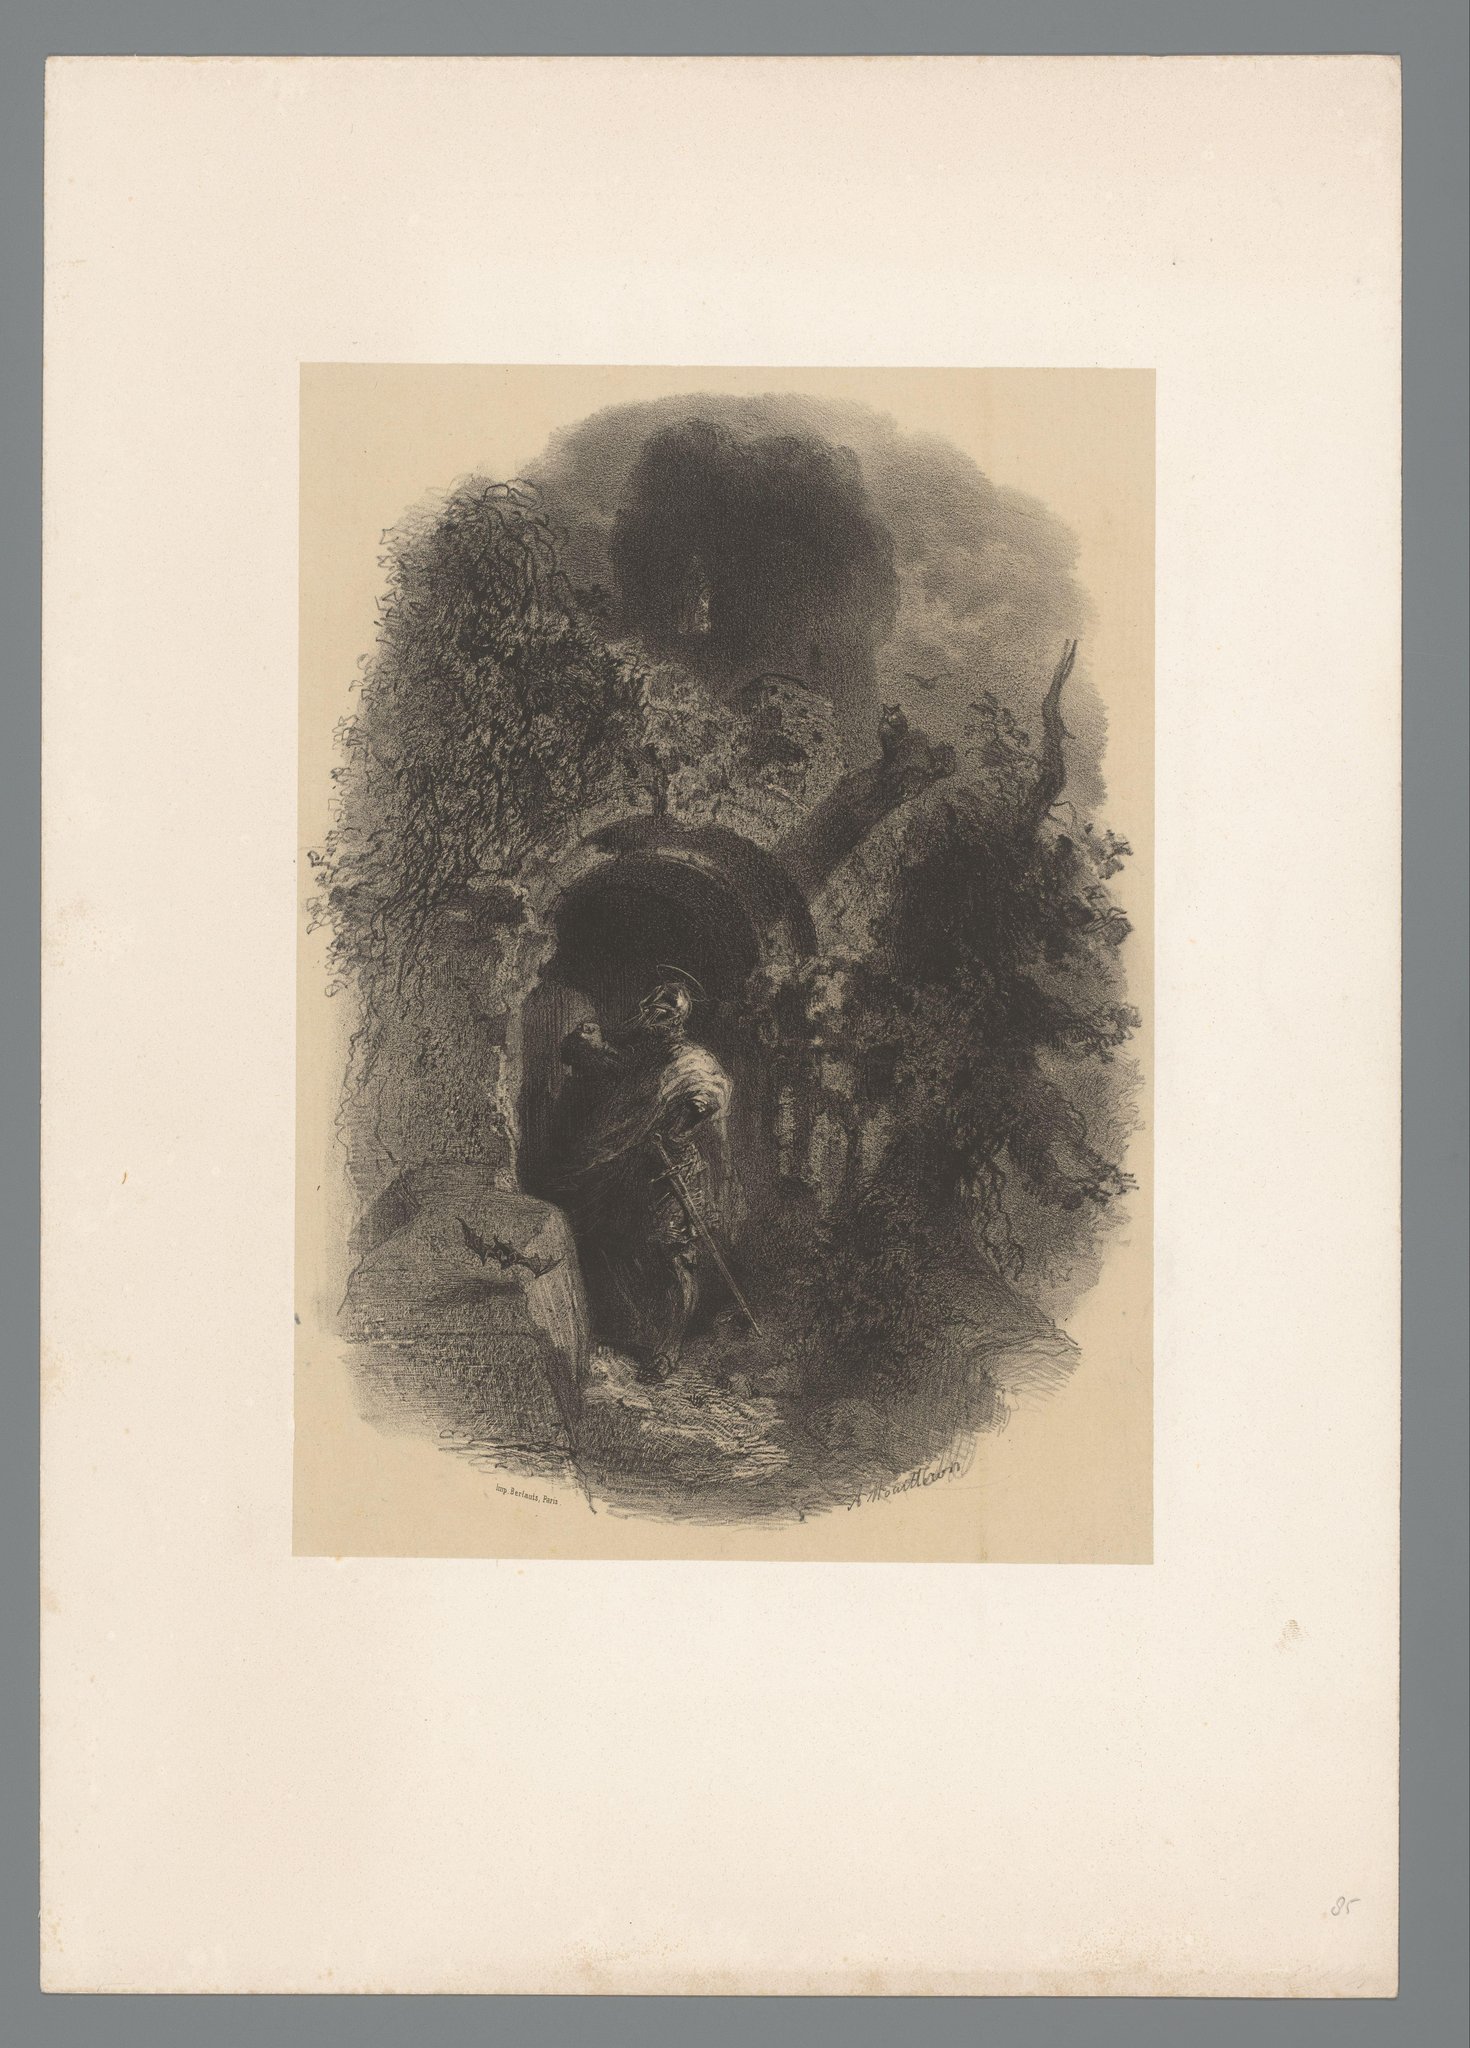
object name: print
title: Man in harnas klopt 's nachts op deur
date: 1830-1880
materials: paper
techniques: lithograph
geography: paris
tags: helmet, night, closed door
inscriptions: signature: ‘AM’, collector's mark: Lugt 2166